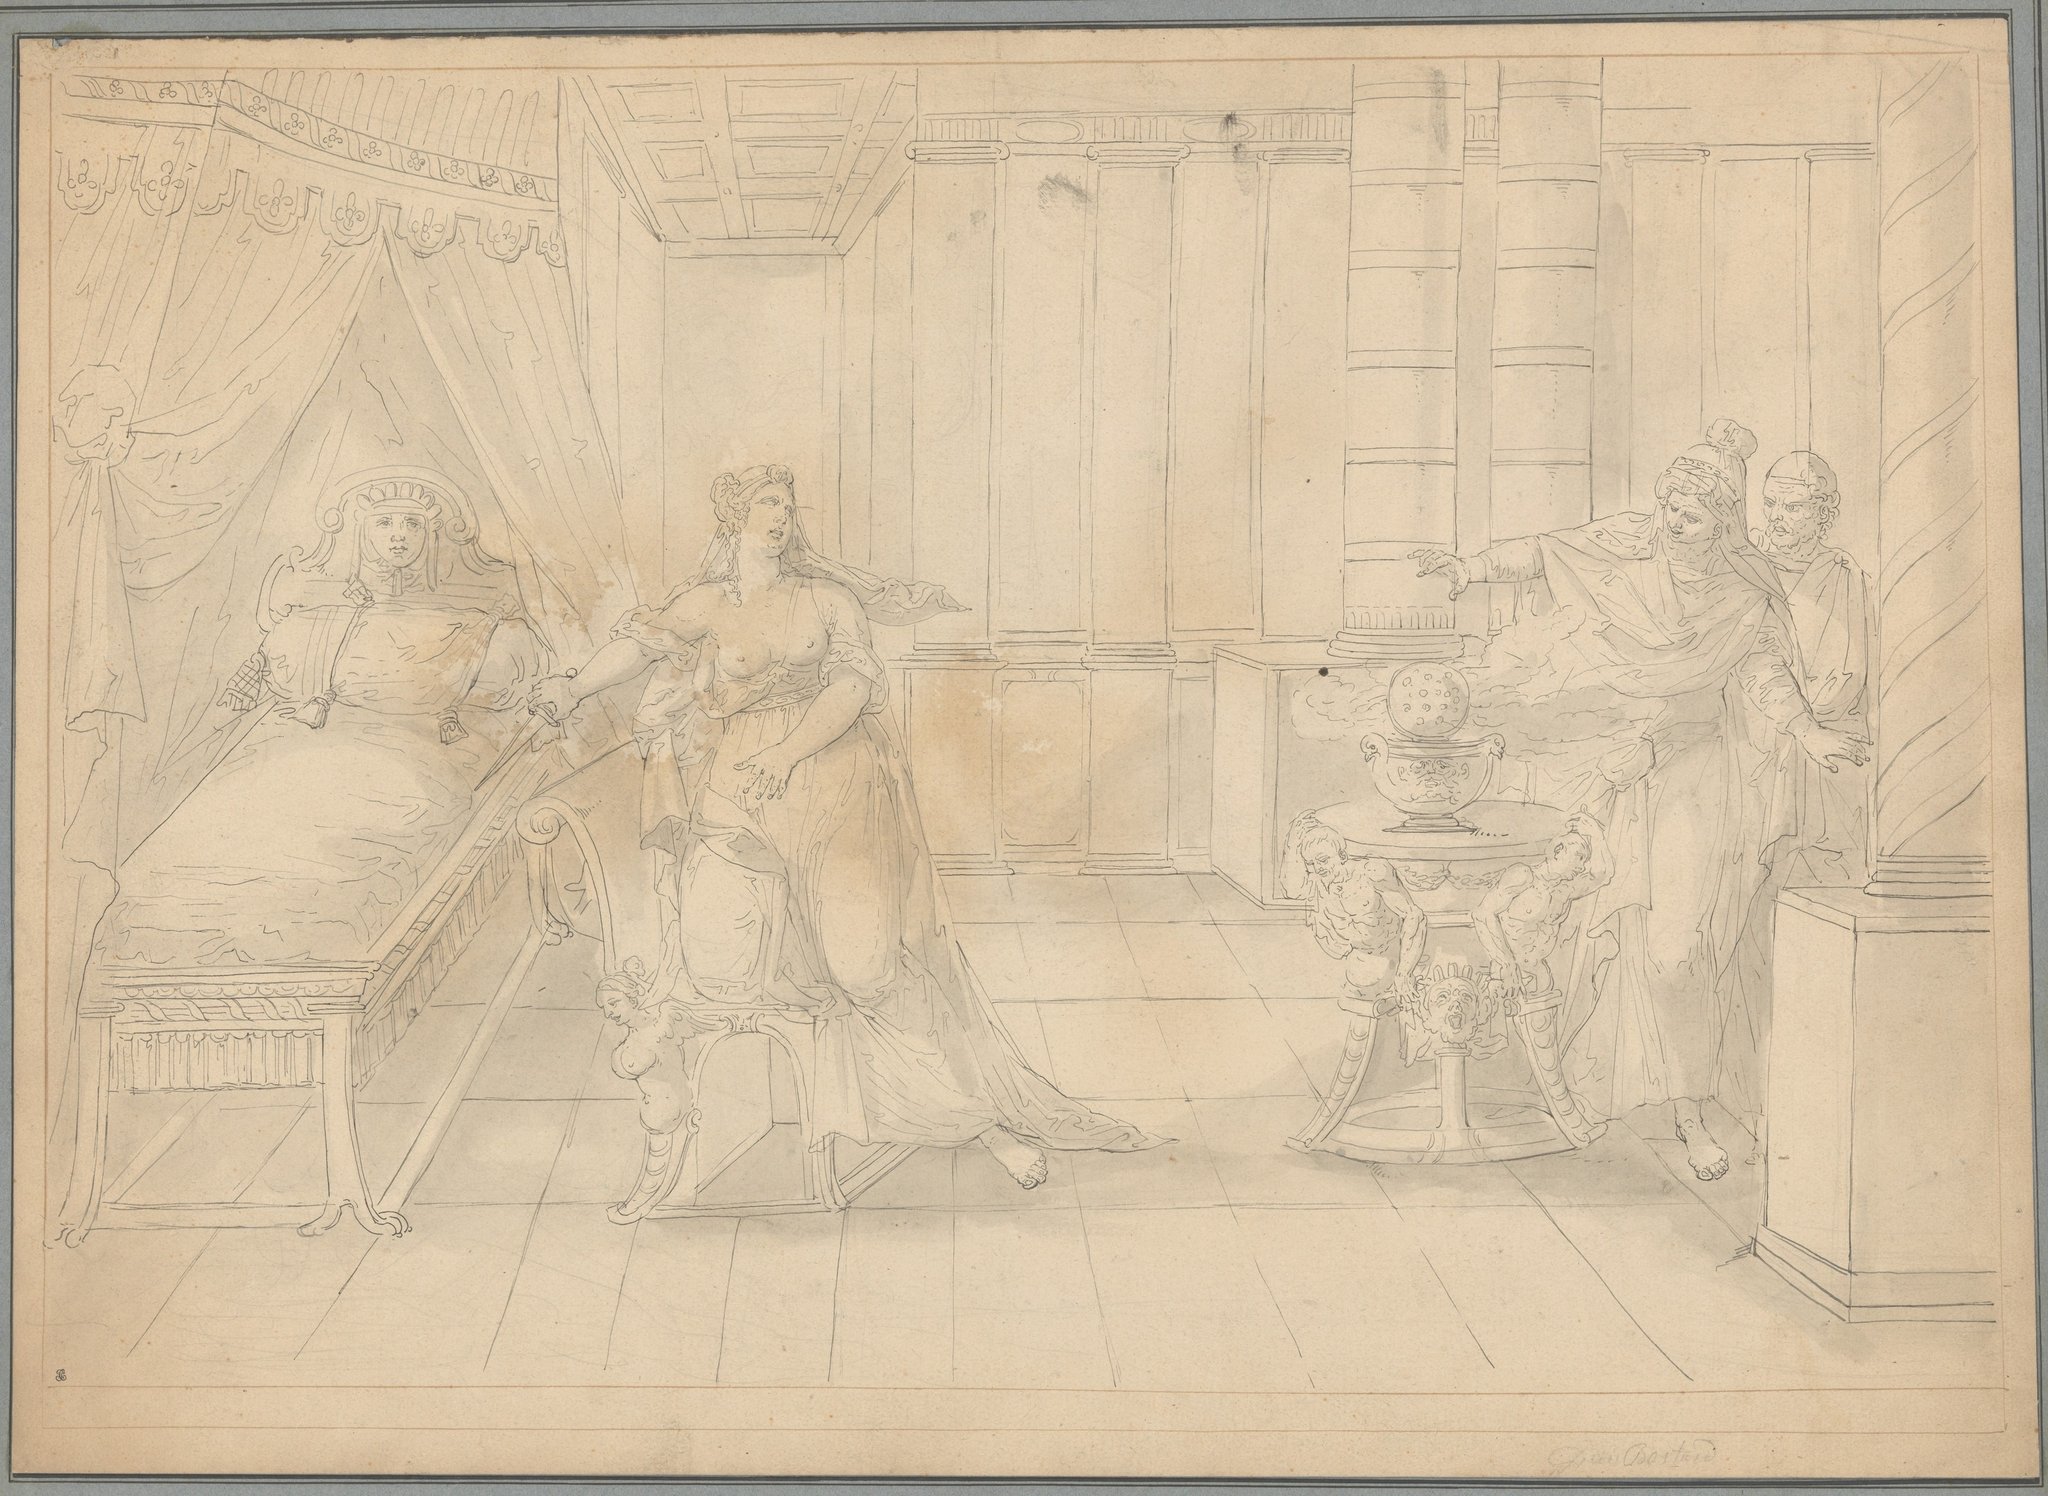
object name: drawing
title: A Scene from Ancient History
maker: françois boitard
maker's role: artist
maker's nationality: french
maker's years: 1670-1715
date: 1670-1730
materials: ink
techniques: pen, wash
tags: women,female nudes